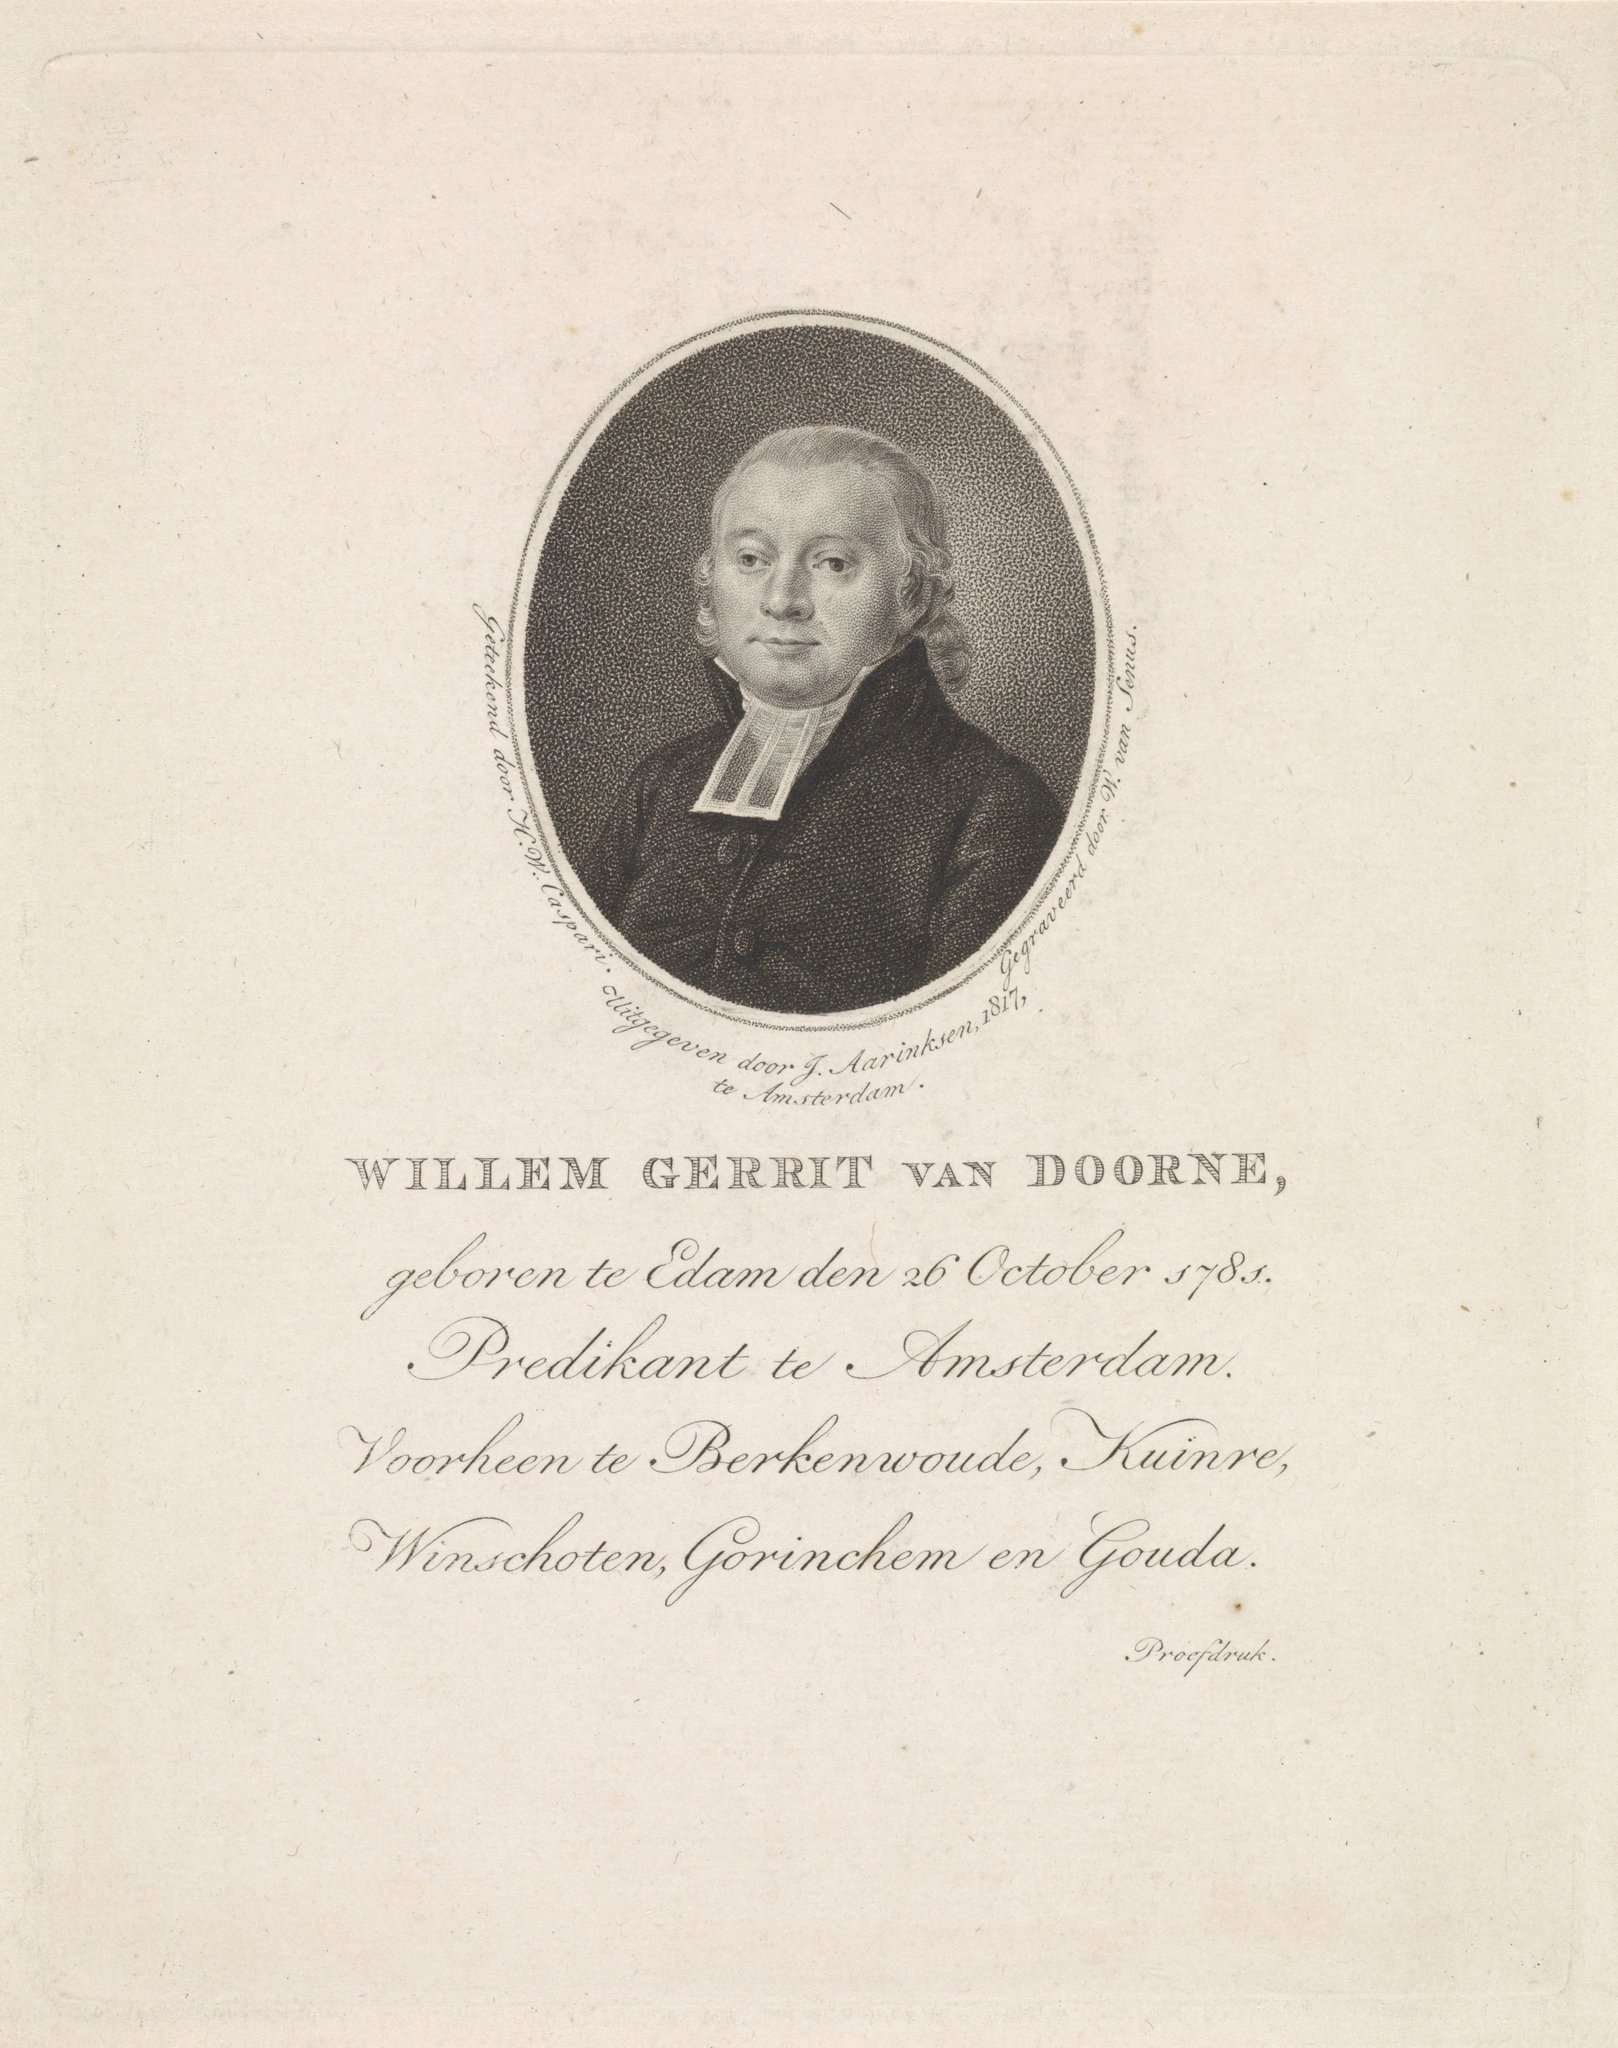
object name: print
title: Portret van Willem Gerrit van Doorne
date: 1817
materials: paper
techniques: engraving, etching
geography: amsterdam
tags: willem gerrit van doorne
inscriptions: collector's mark: Lugt 2228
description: Portret van Willem Gerrit van Doorne, hervormd predikant te Amsterdam.